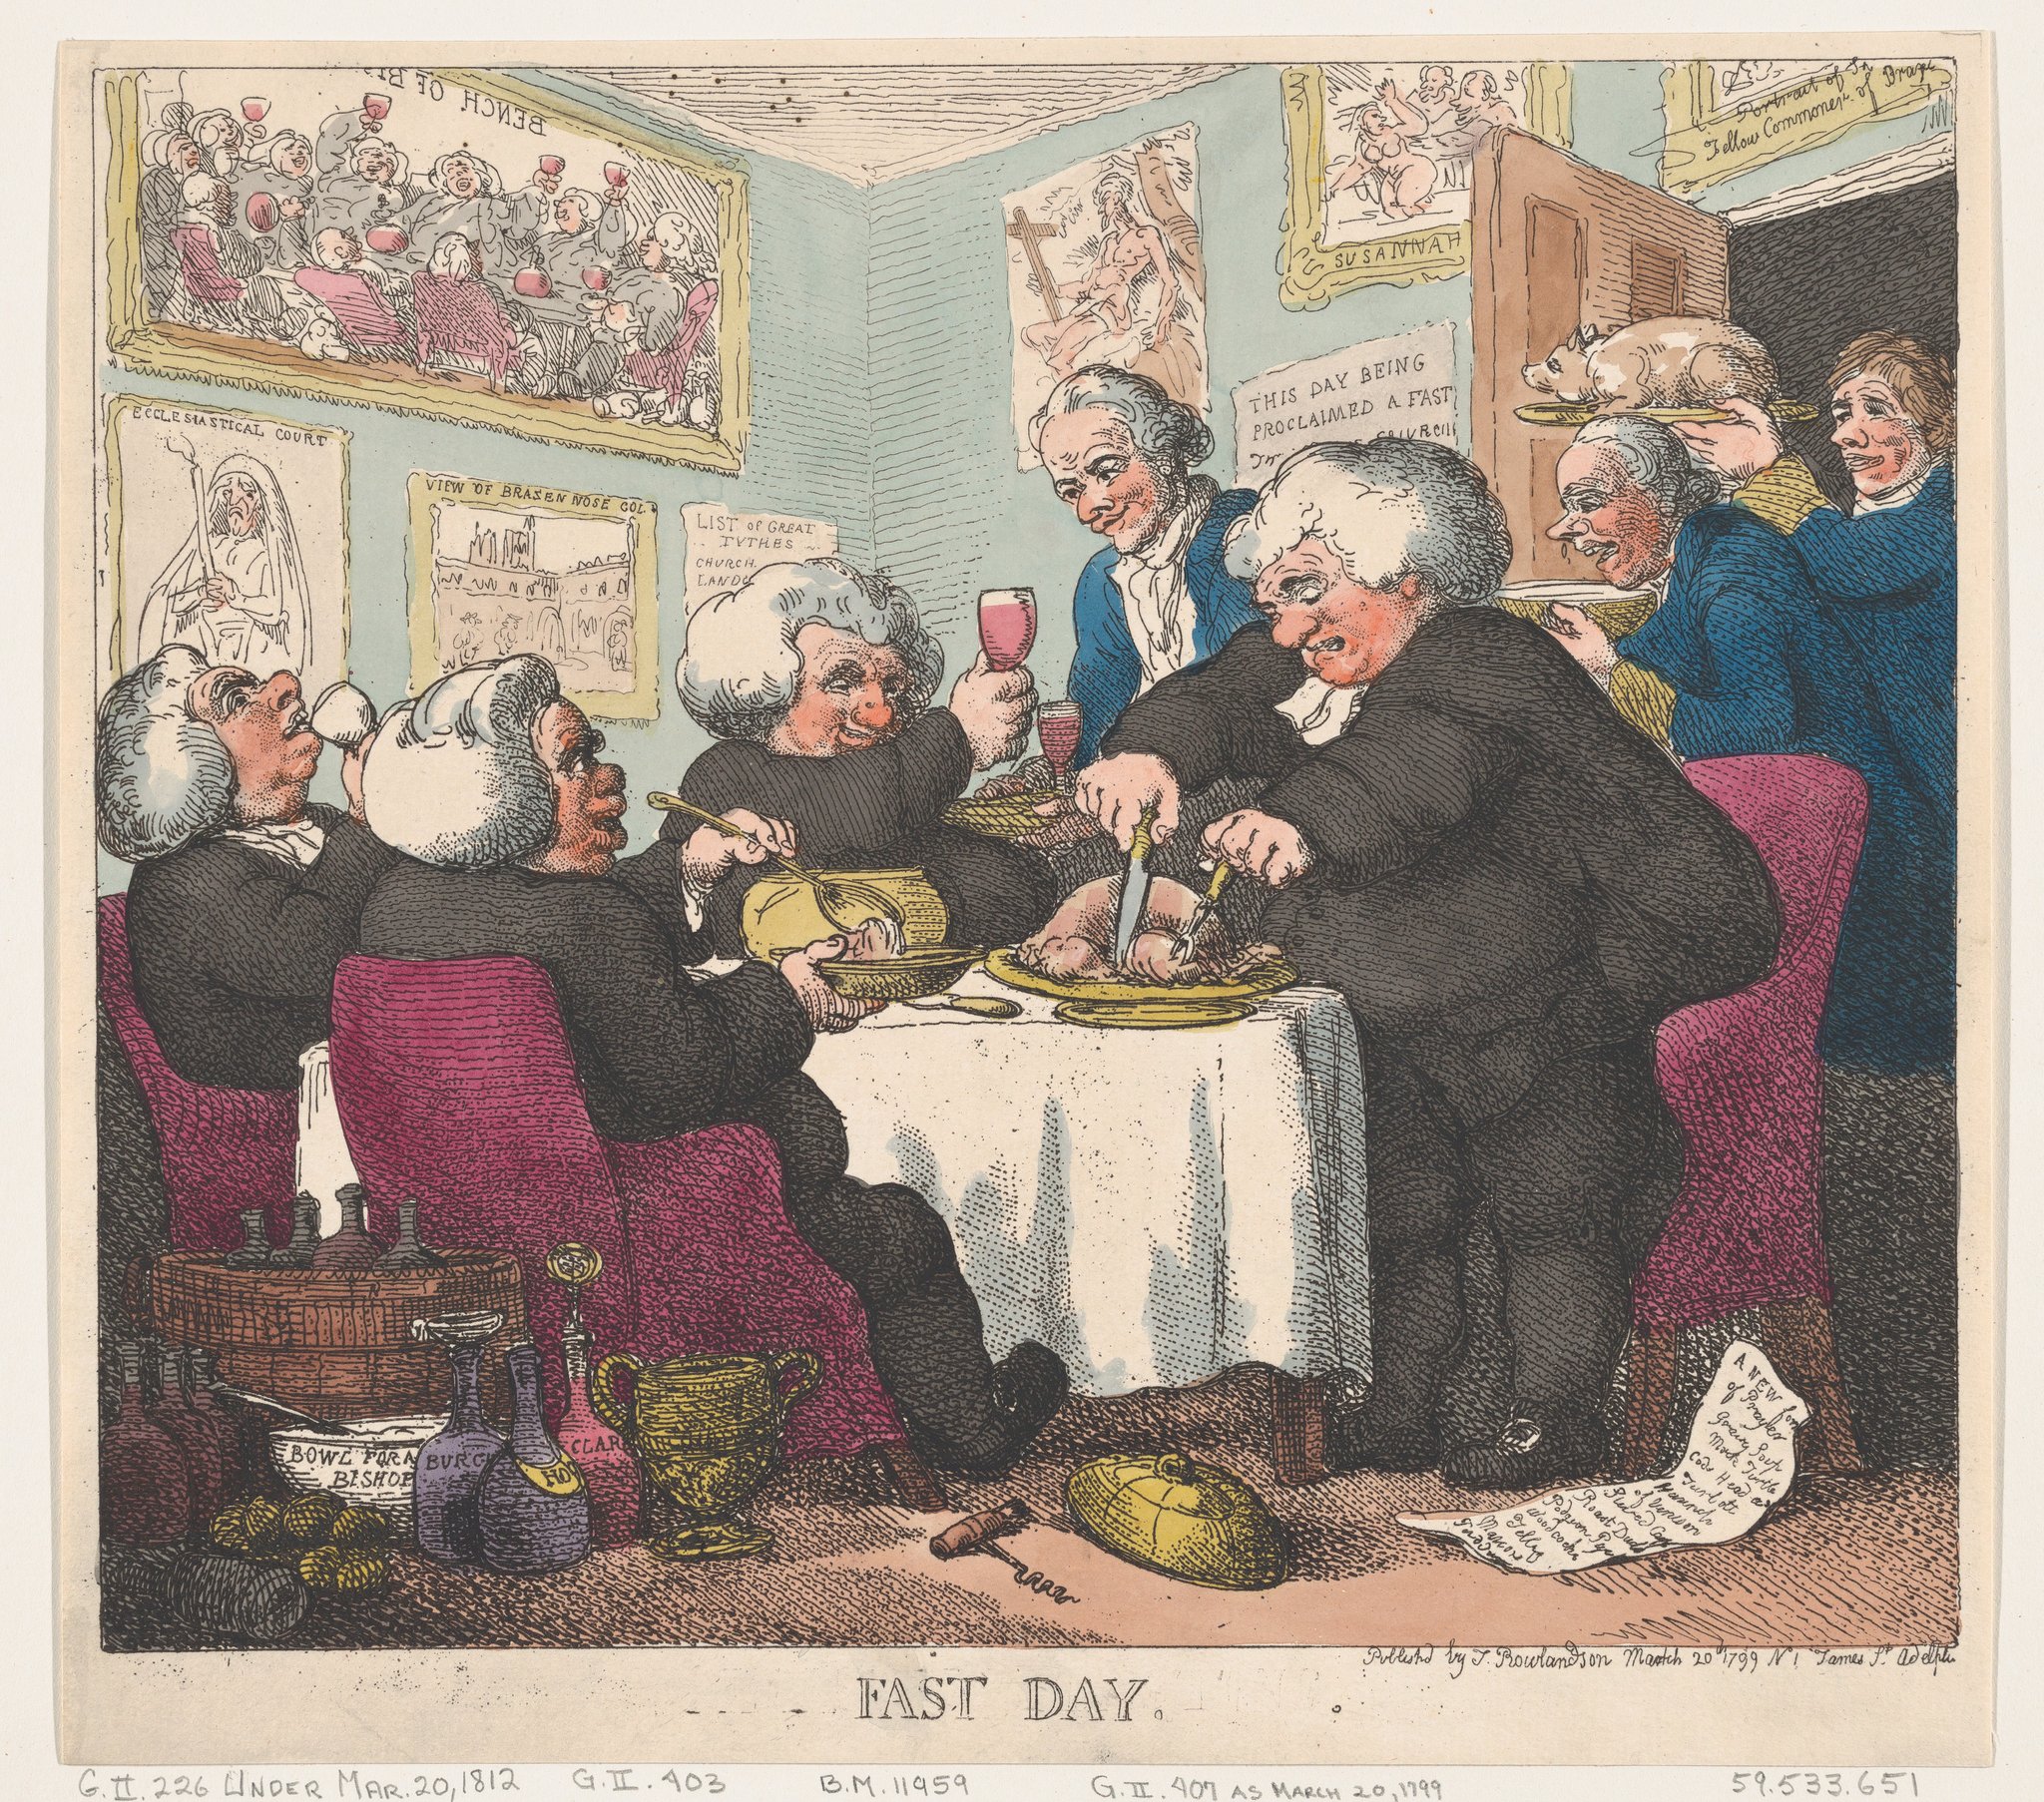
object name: print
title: Fast Day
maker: thomas rowlandson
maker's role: artist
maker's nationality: british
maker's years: 1757-1827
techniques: etching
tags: satire,men,dining